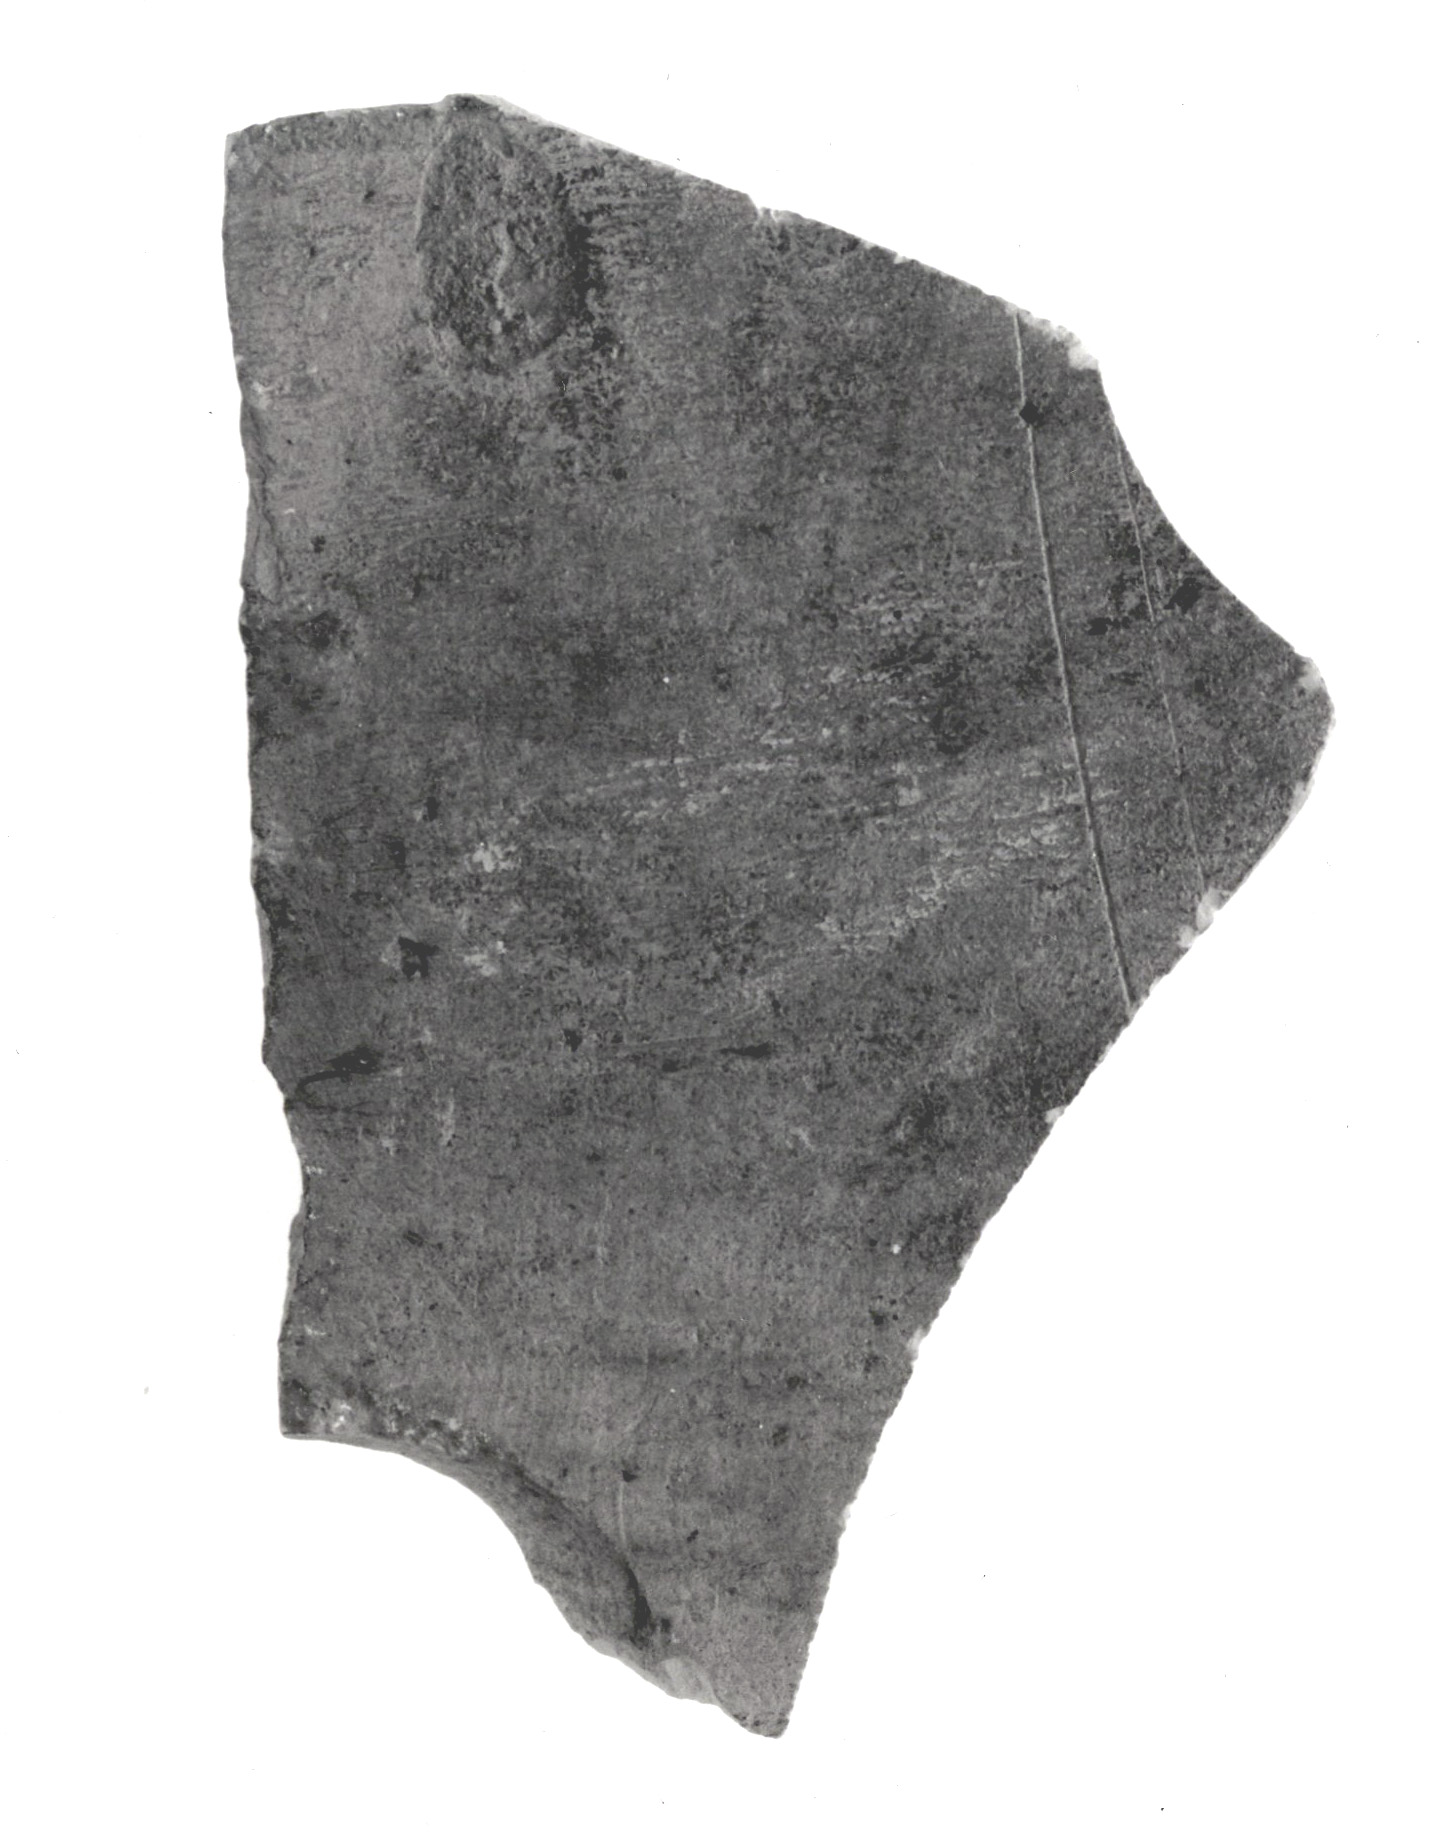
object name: relief, tomb of nespekashuty, wall casing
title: Wall casing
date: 664-610 BCE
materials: limestone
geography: egypt